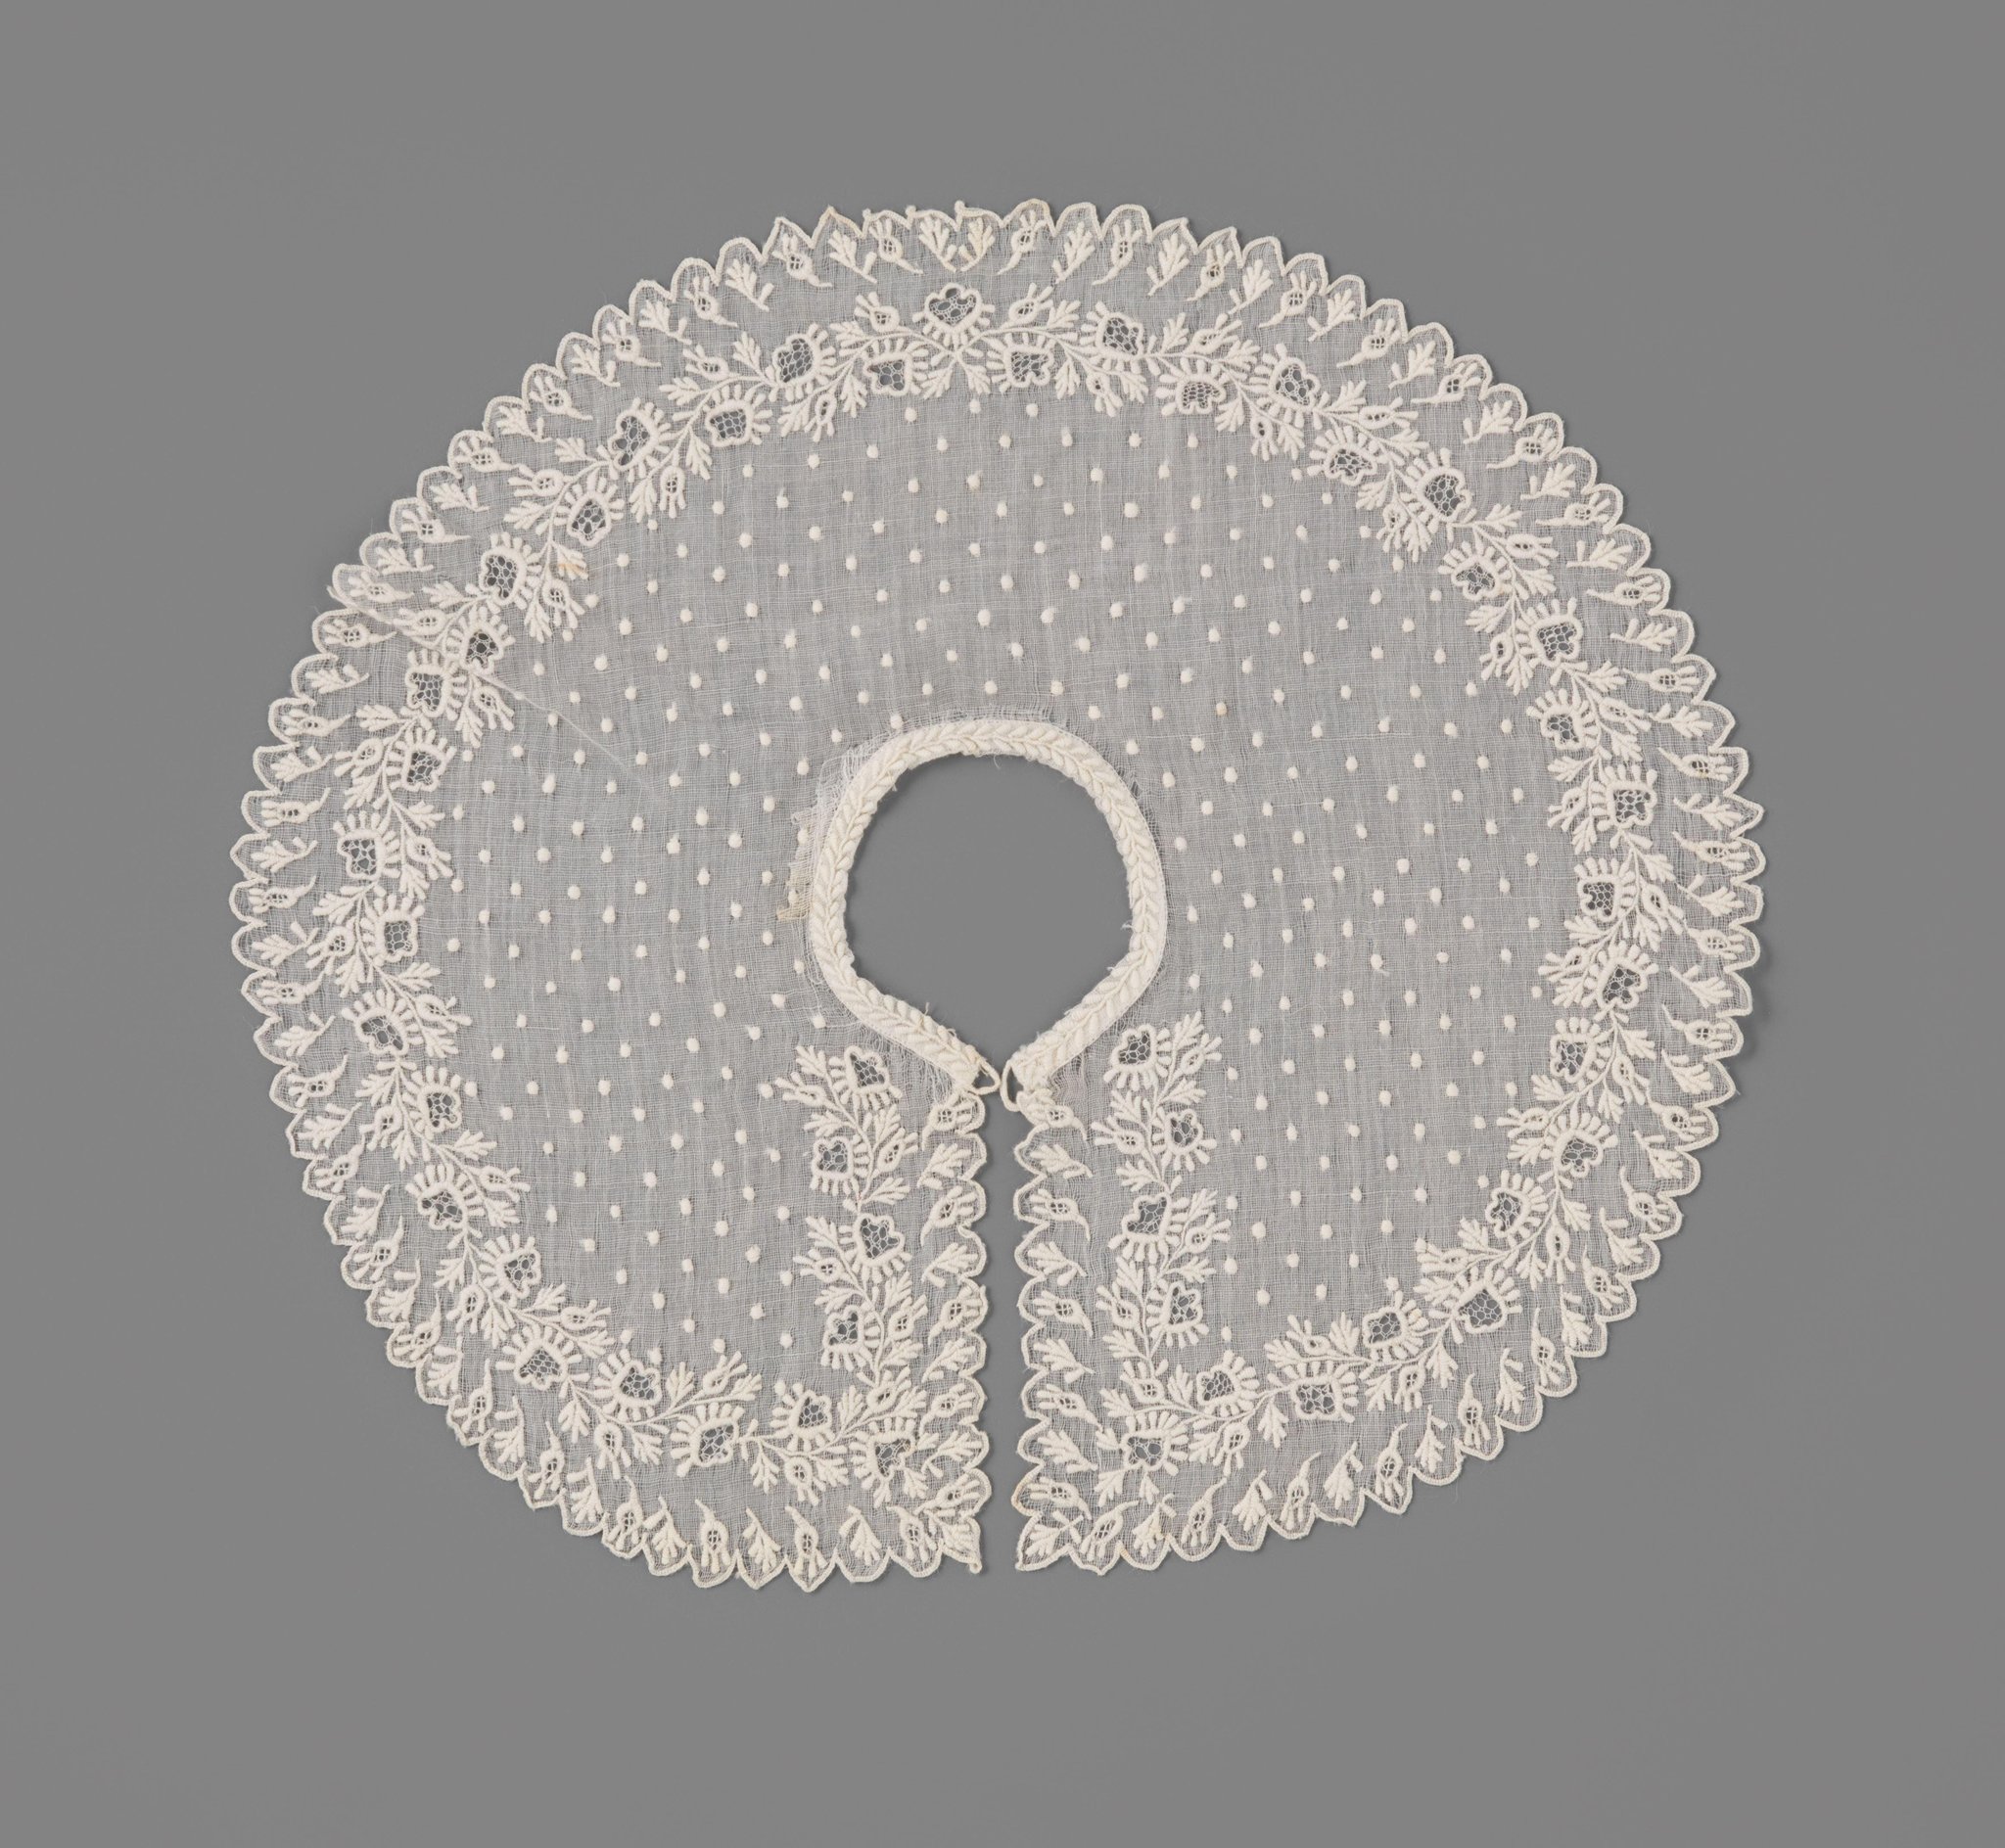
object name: collar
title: Kinderkraag van batist, afgezet met een schulprand en versierd met witwerk in de vorm van bloem- en bladranken en moesjes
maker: Anonymous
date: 1825-1835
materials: textile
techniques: embroidery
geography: netherlands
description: Kinderkraag van neteldoek met wit borduurwerk van een randje van opengewerkte naaldkant roosjes met knopjes en moesjes. biedermeier. Model: liggend rond kraagje met puntschulpjes. Boordje plat en gevoerd, met borduursel versierd. Sluit met twee lusjes, die op het jurkje kunnen worden geknoopt. Patroon: Binnenrand: beginnend bij een middenroosje gaan links en rechts twee zeer gesloten golvende takjes. Elk heeft links en rechts verspringende roosjes-en profil-met cordons afgewerkt en met naaldkantsteken opgevuld. Daartussendoor staan gevederde blaadjes en rozenknopjes. Buitenrandje met een hangend knopje, afgewisseld door een hangend blaadje, elk per schulpje naar voren wijzend. Toestand: Zeer fijn gestopt, bij het boordje. Daarlangs ook enige geschifte plekjes.